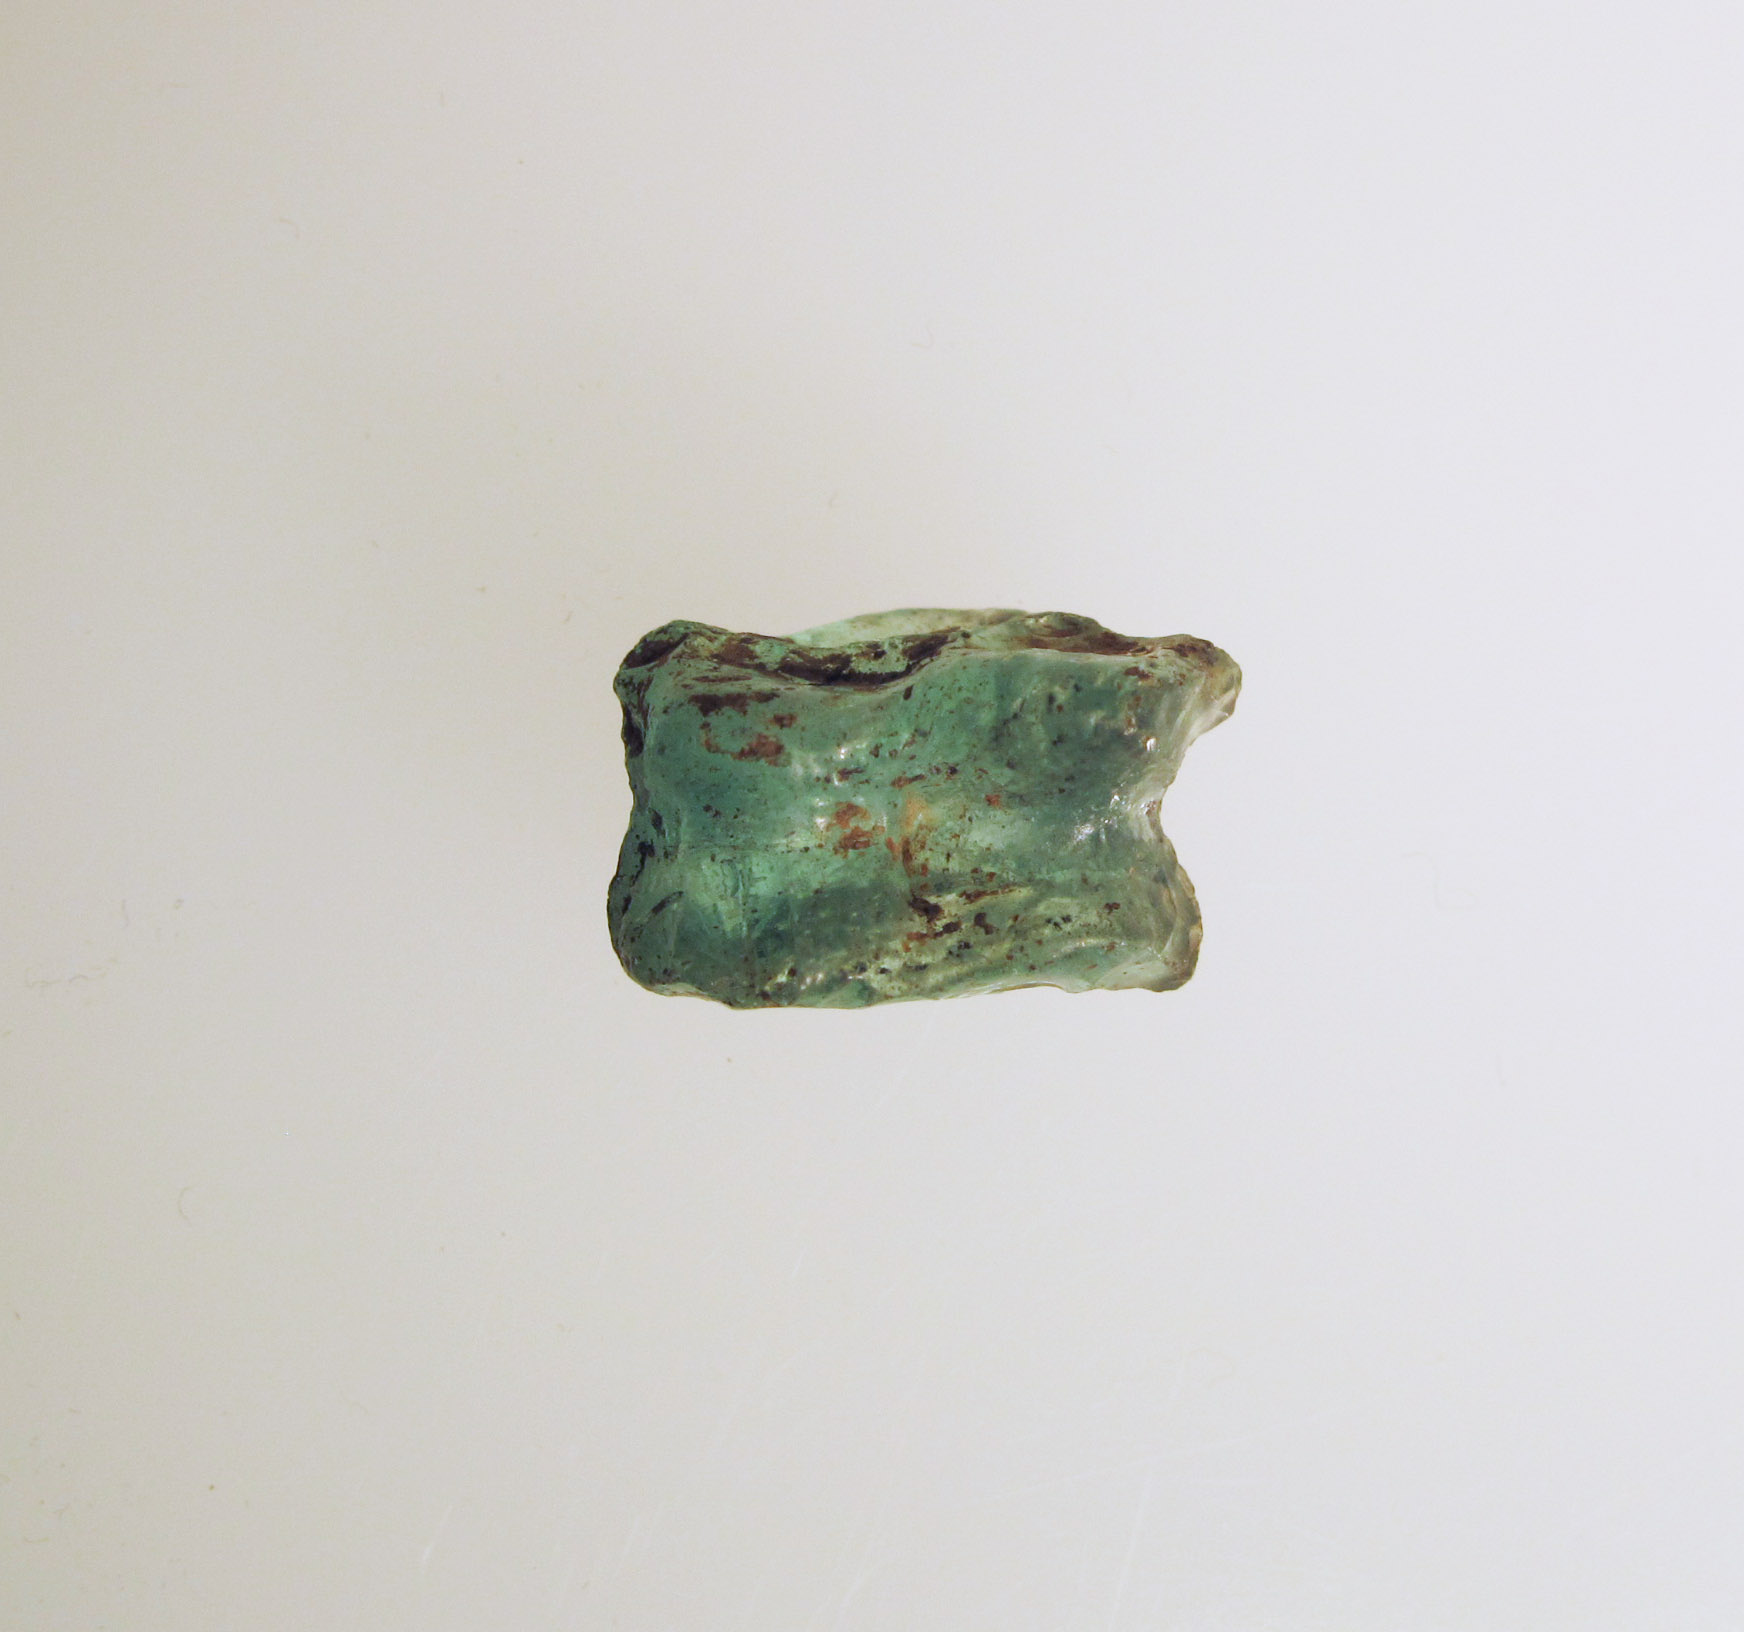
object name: astragal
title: Glass astragal (knucklebone)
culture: greek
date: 300-101 BCE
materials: glass